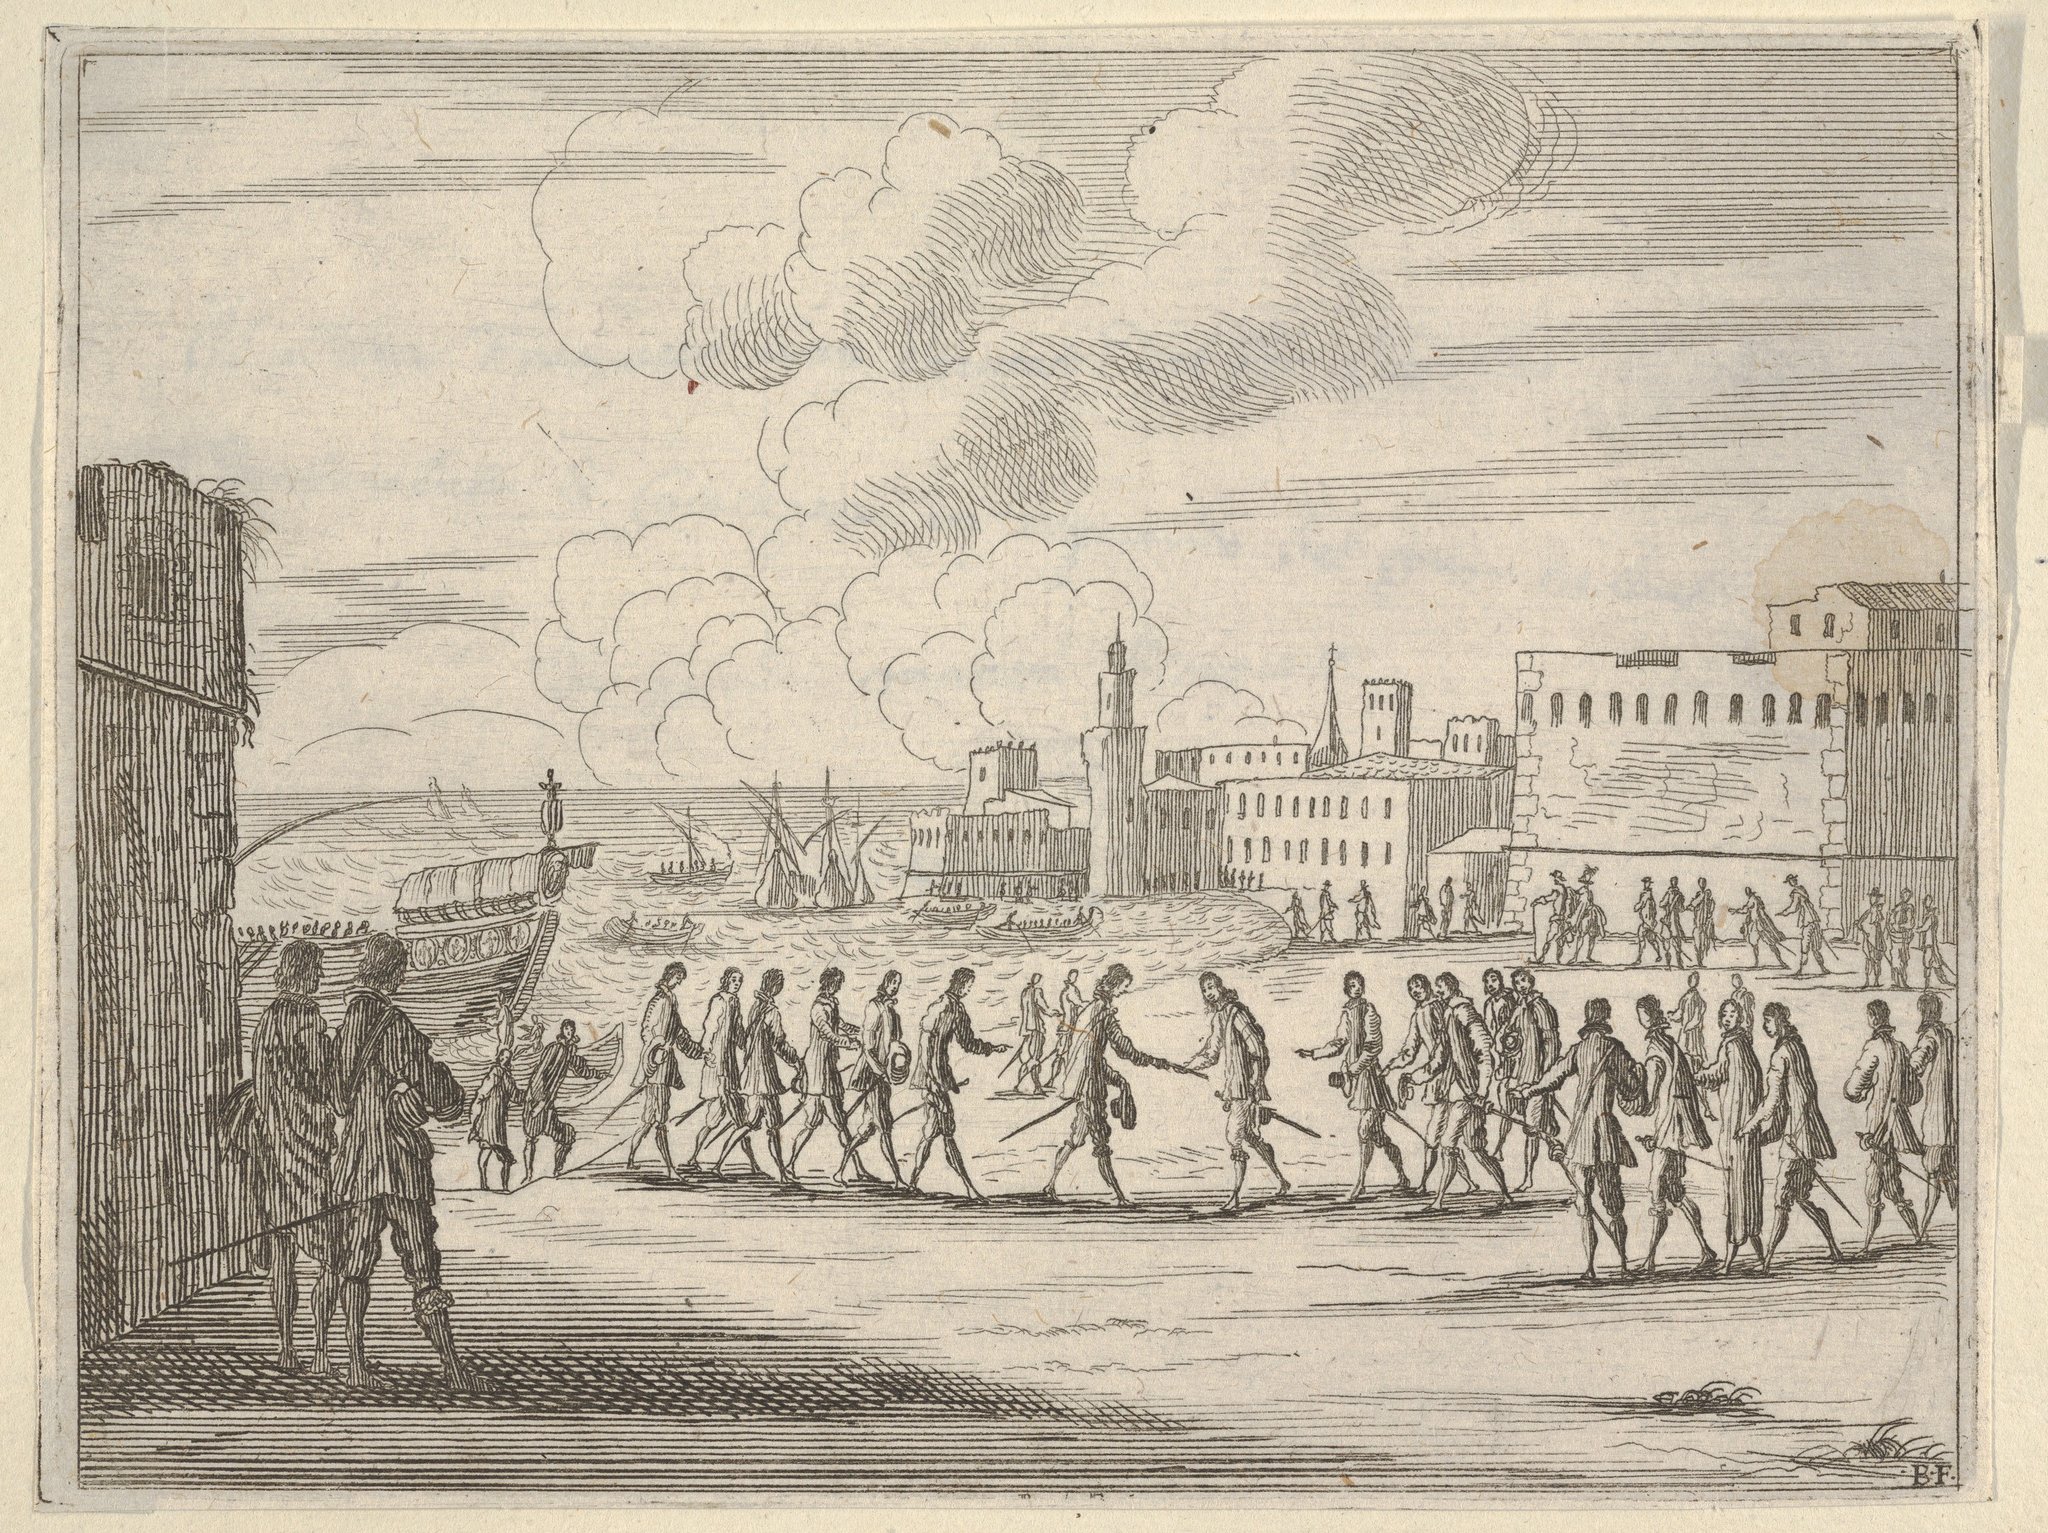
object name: print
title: Francesco I d'Este is Named the Deputy of the Catholilc King and is Sent to Catalogna, from "L'Idea di un Principe ed Eroe Cristiano in Francesco I d'Este, di Modena e Reggio Duca VIII [...]"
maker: bartolomeo fenice (fénis)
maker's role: artist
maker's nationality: italian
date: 1659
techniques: etching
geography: italy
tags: buildings,men,boats